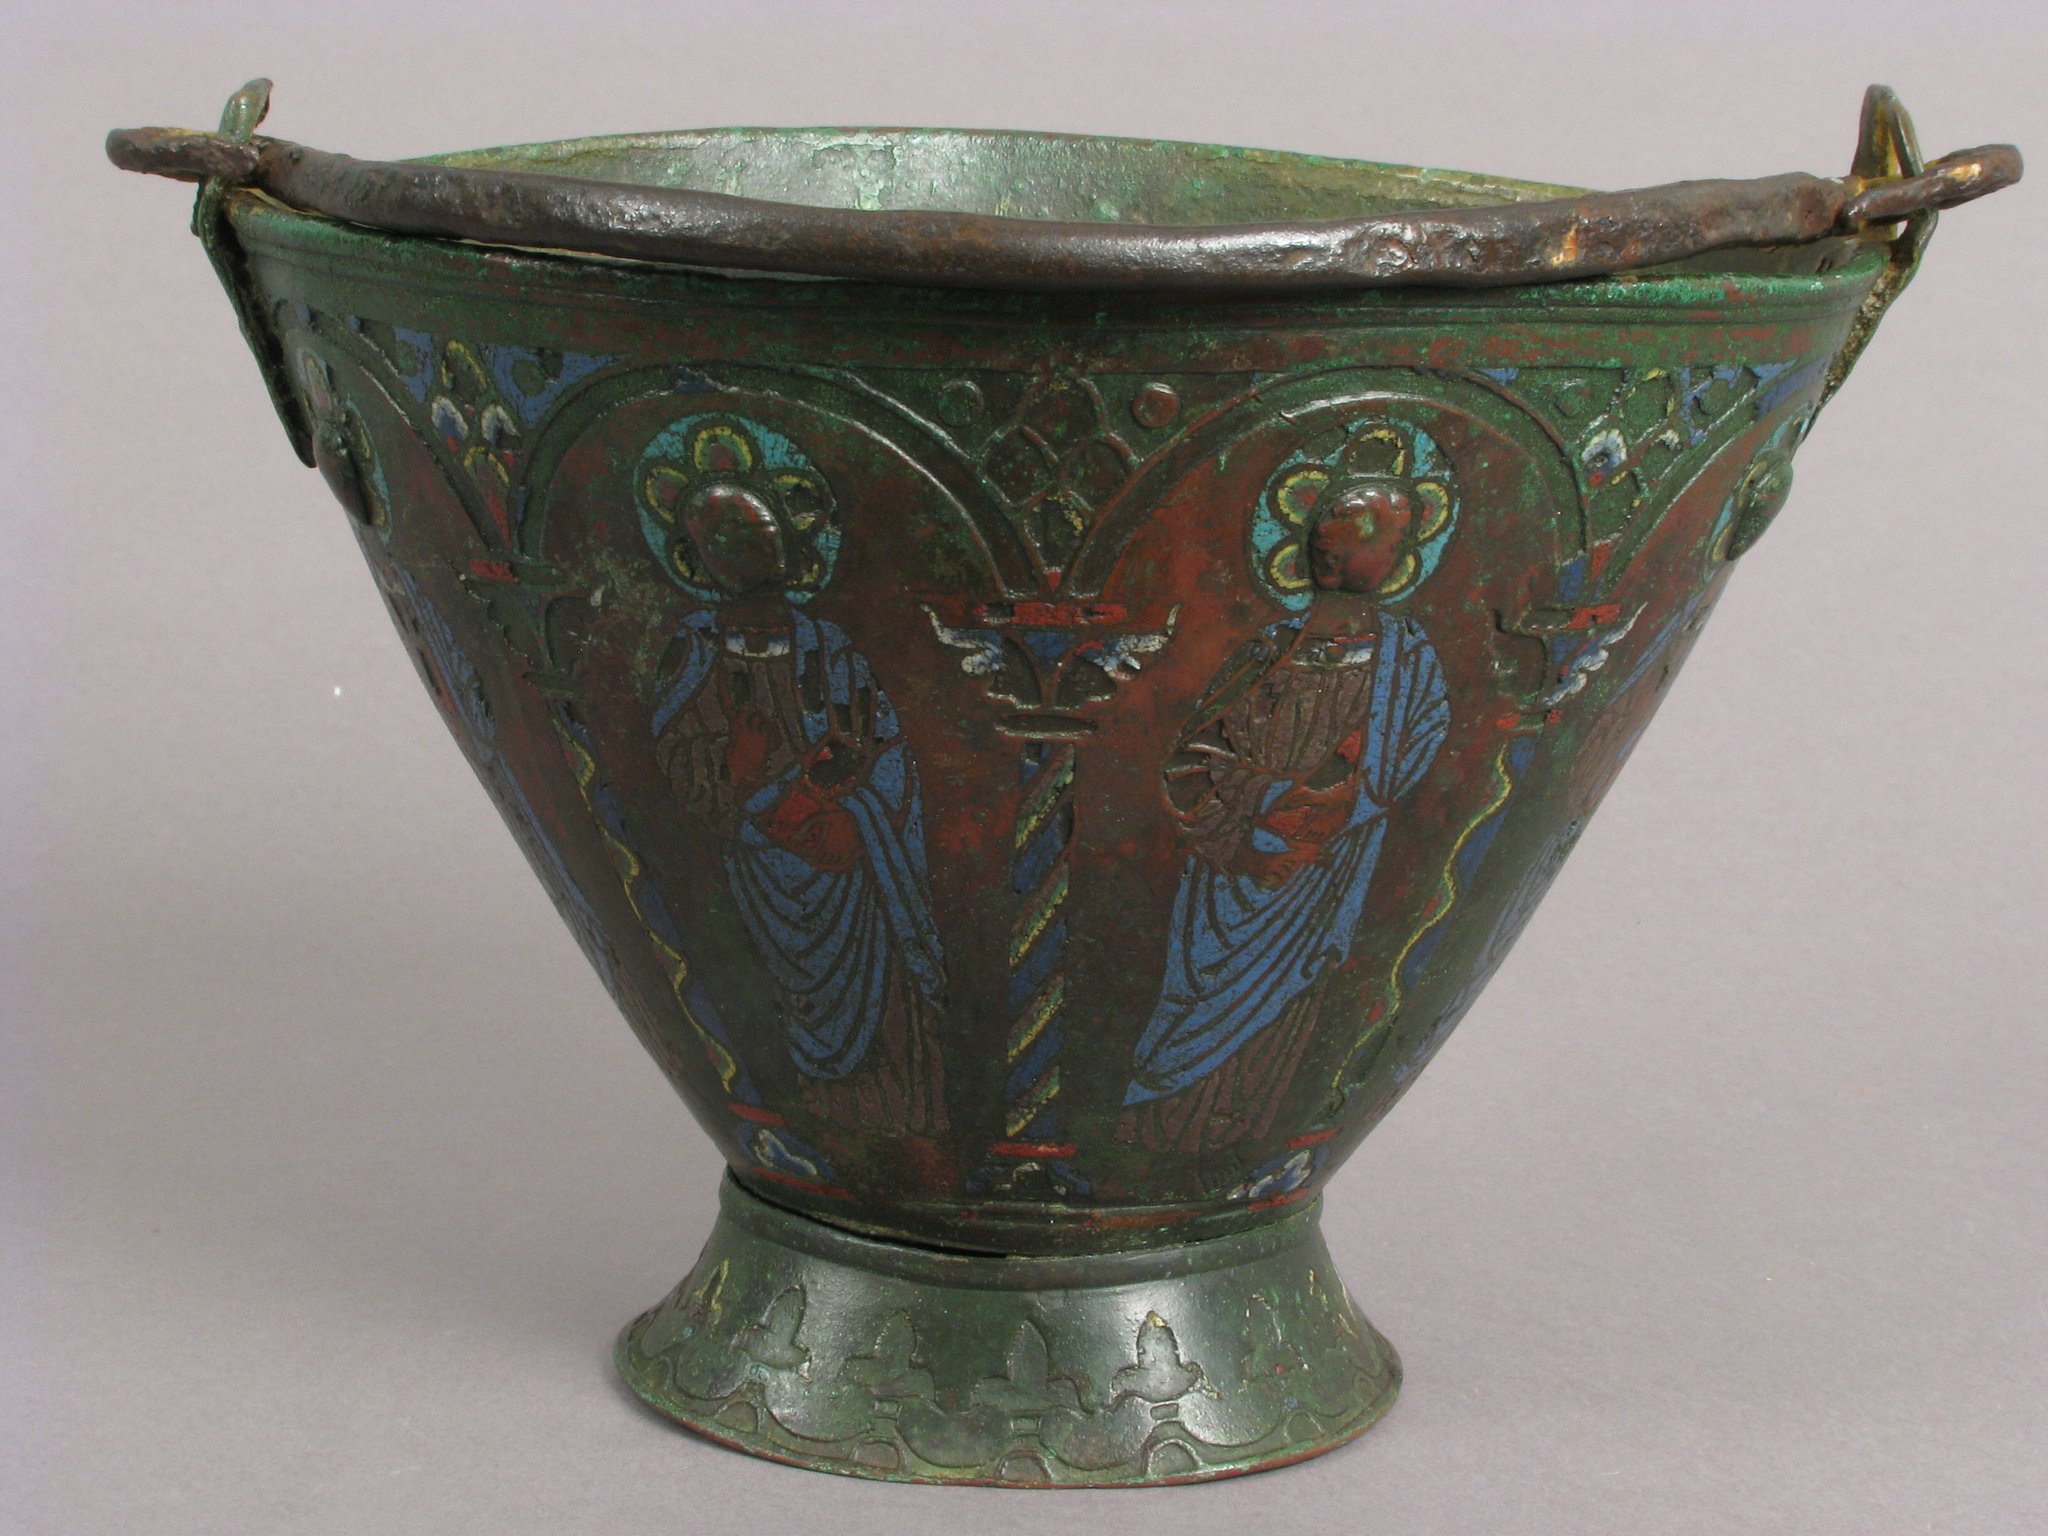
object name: situla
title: Situla (Bucket for Holy Water) with Saint Peter and Other Saints, Probably Apostles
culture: french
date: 1200-1225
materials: copper, enamel, gilt, iron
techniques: enamel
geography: france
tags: apostles,saint peter,saints